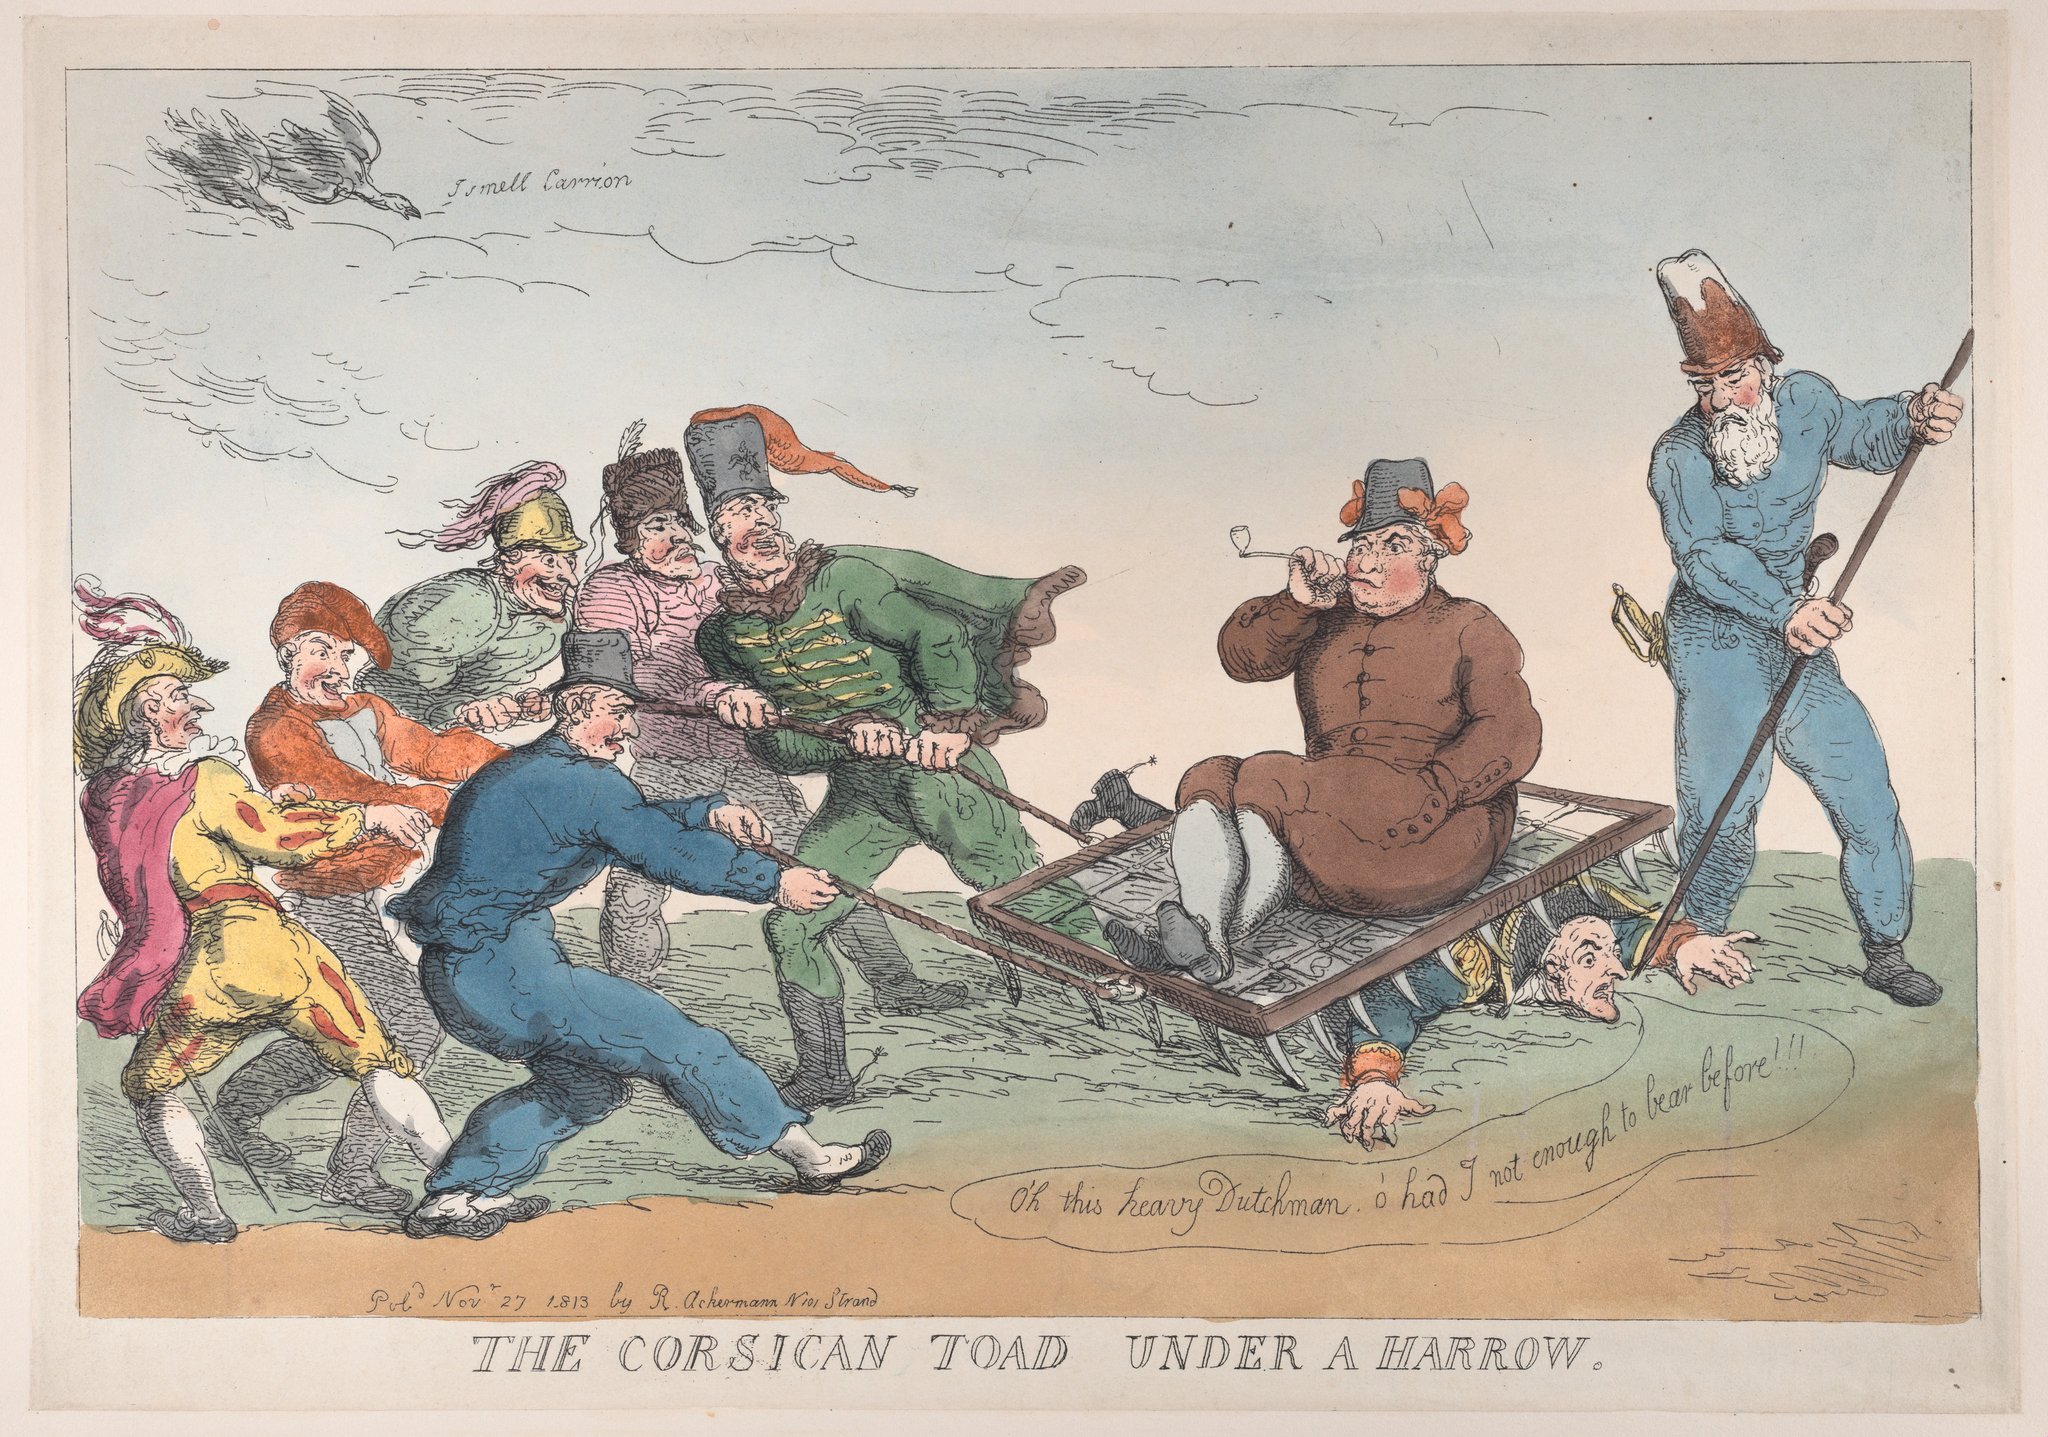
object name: print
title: A Corsican Toad Under a Harrow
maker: thomas rowlandson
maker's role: artist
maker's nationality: british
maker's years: 1757-1827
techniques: etching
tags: satire,napoleon i,men,politics